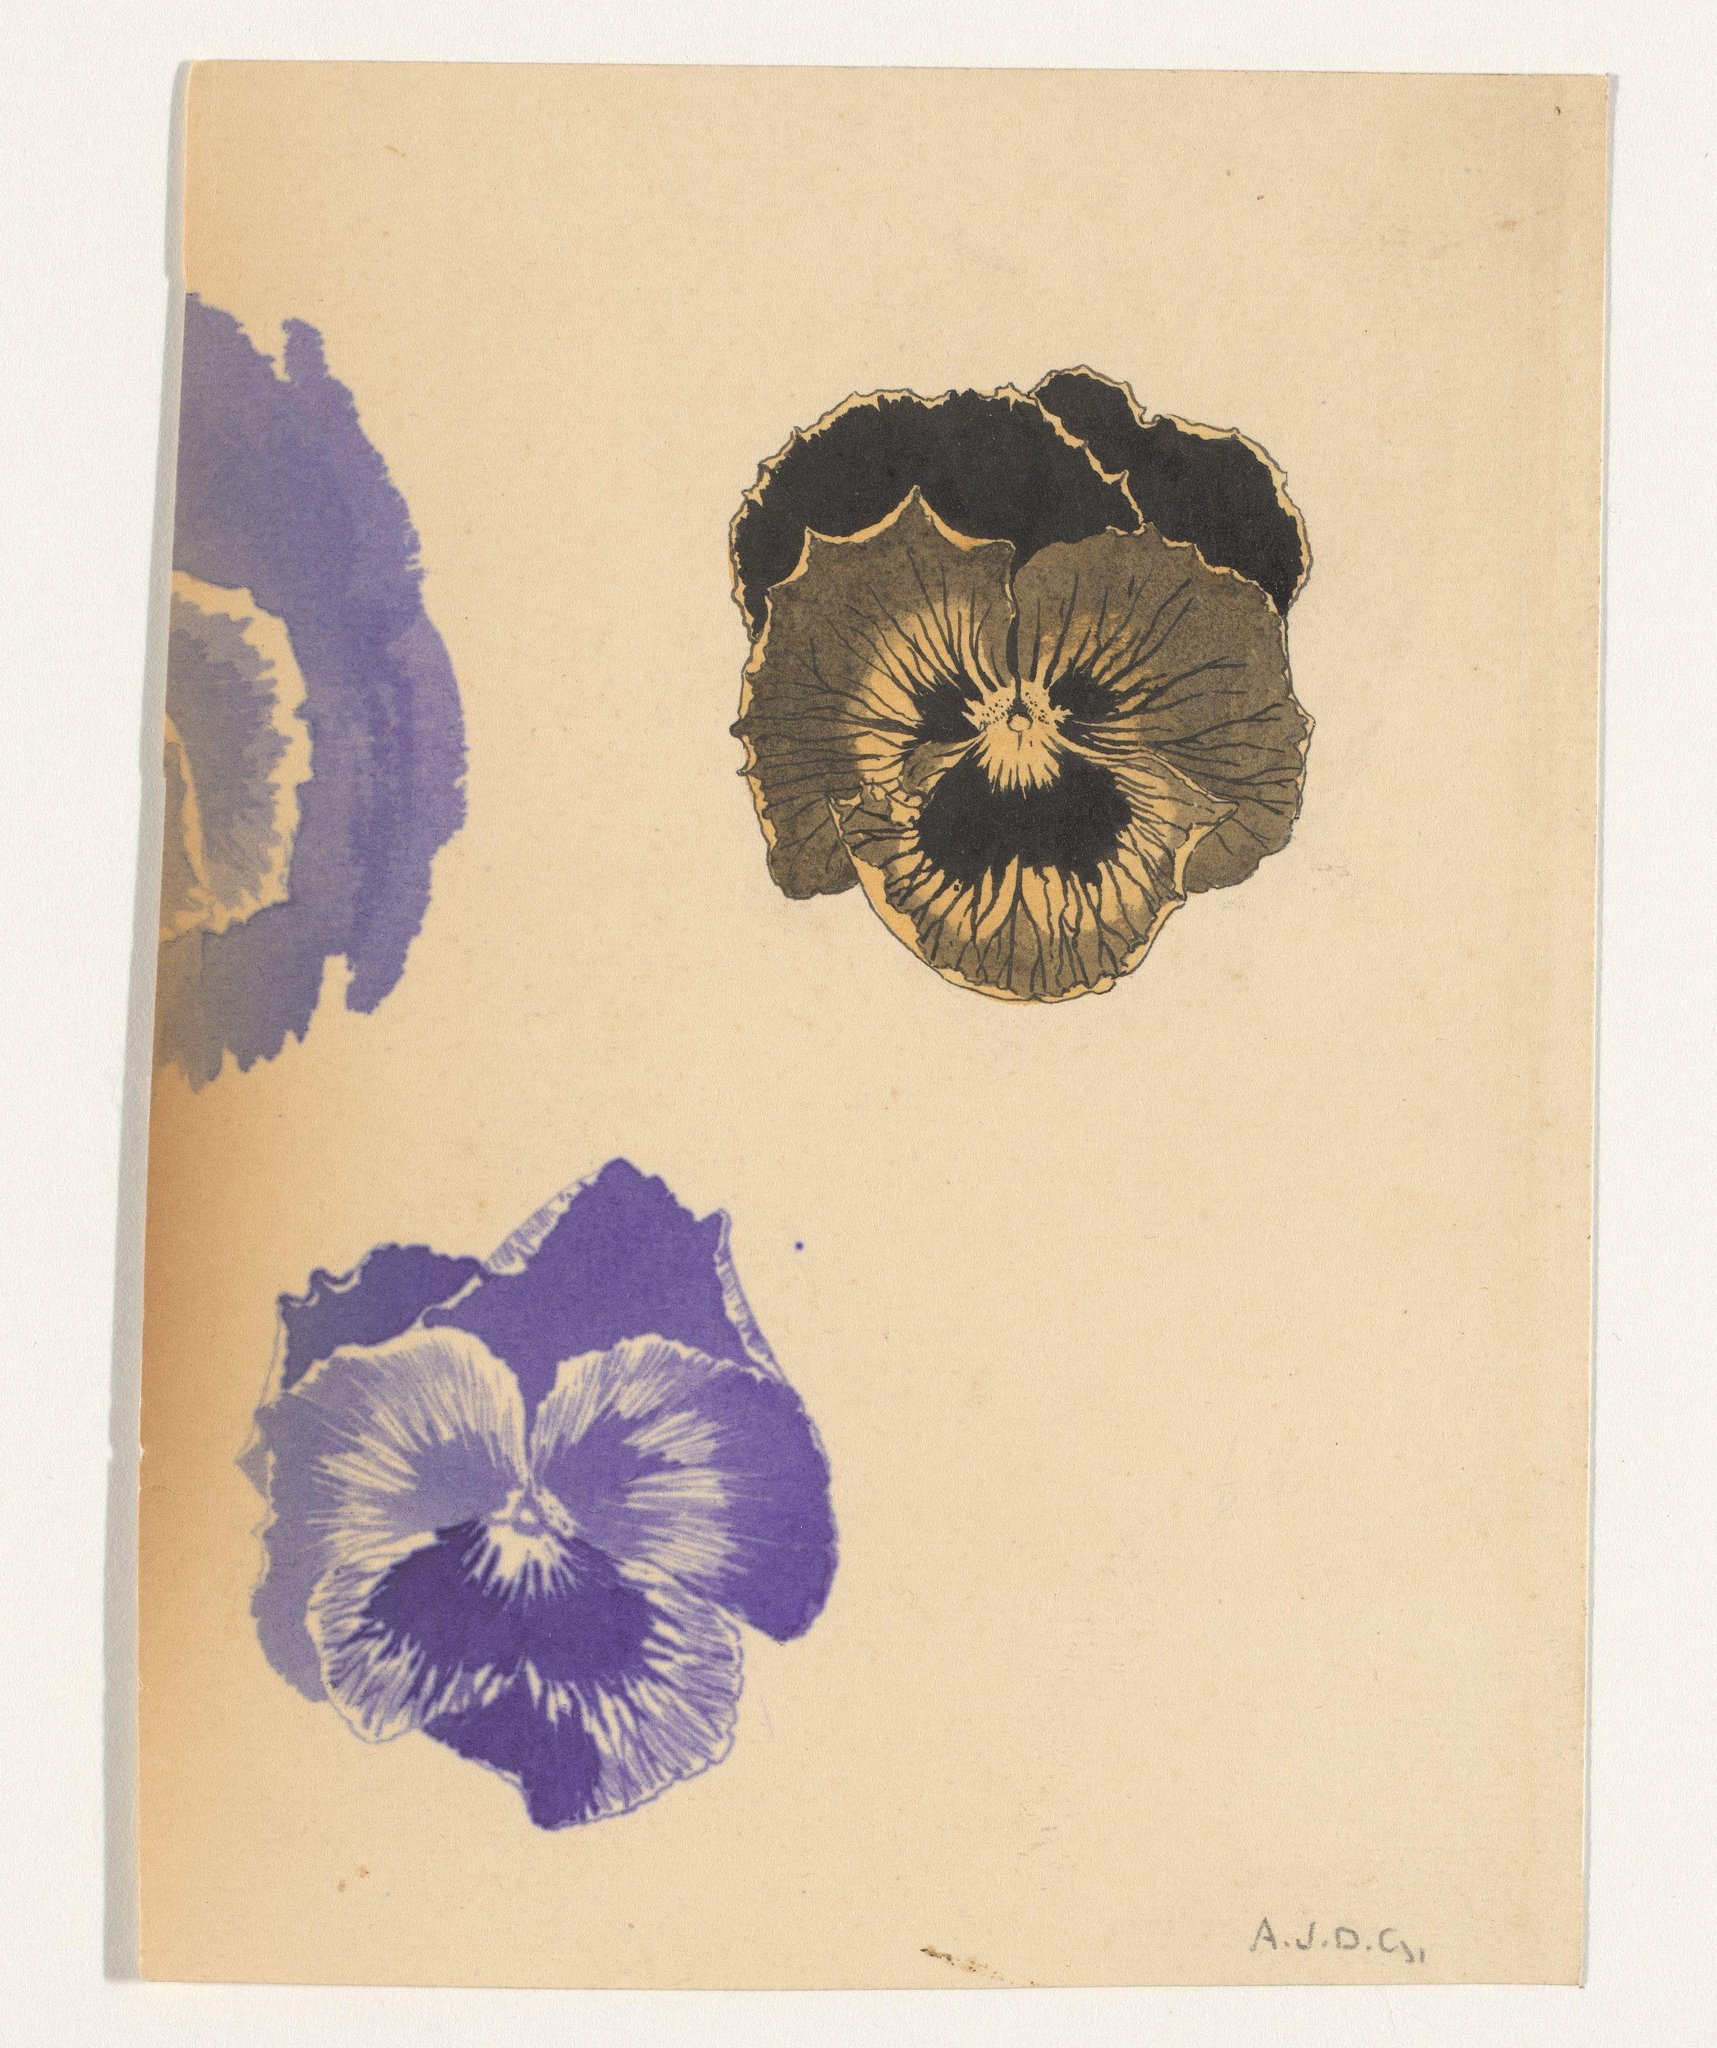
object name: drawing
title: Viooltjes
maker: julie de graag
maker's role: draughtsman, print maker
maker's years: 1877-1924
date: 1887-1924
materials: ink, paper, watercolor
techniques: brush, gum bichromate, pen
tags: flowers: violet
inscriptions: number: ‘89’